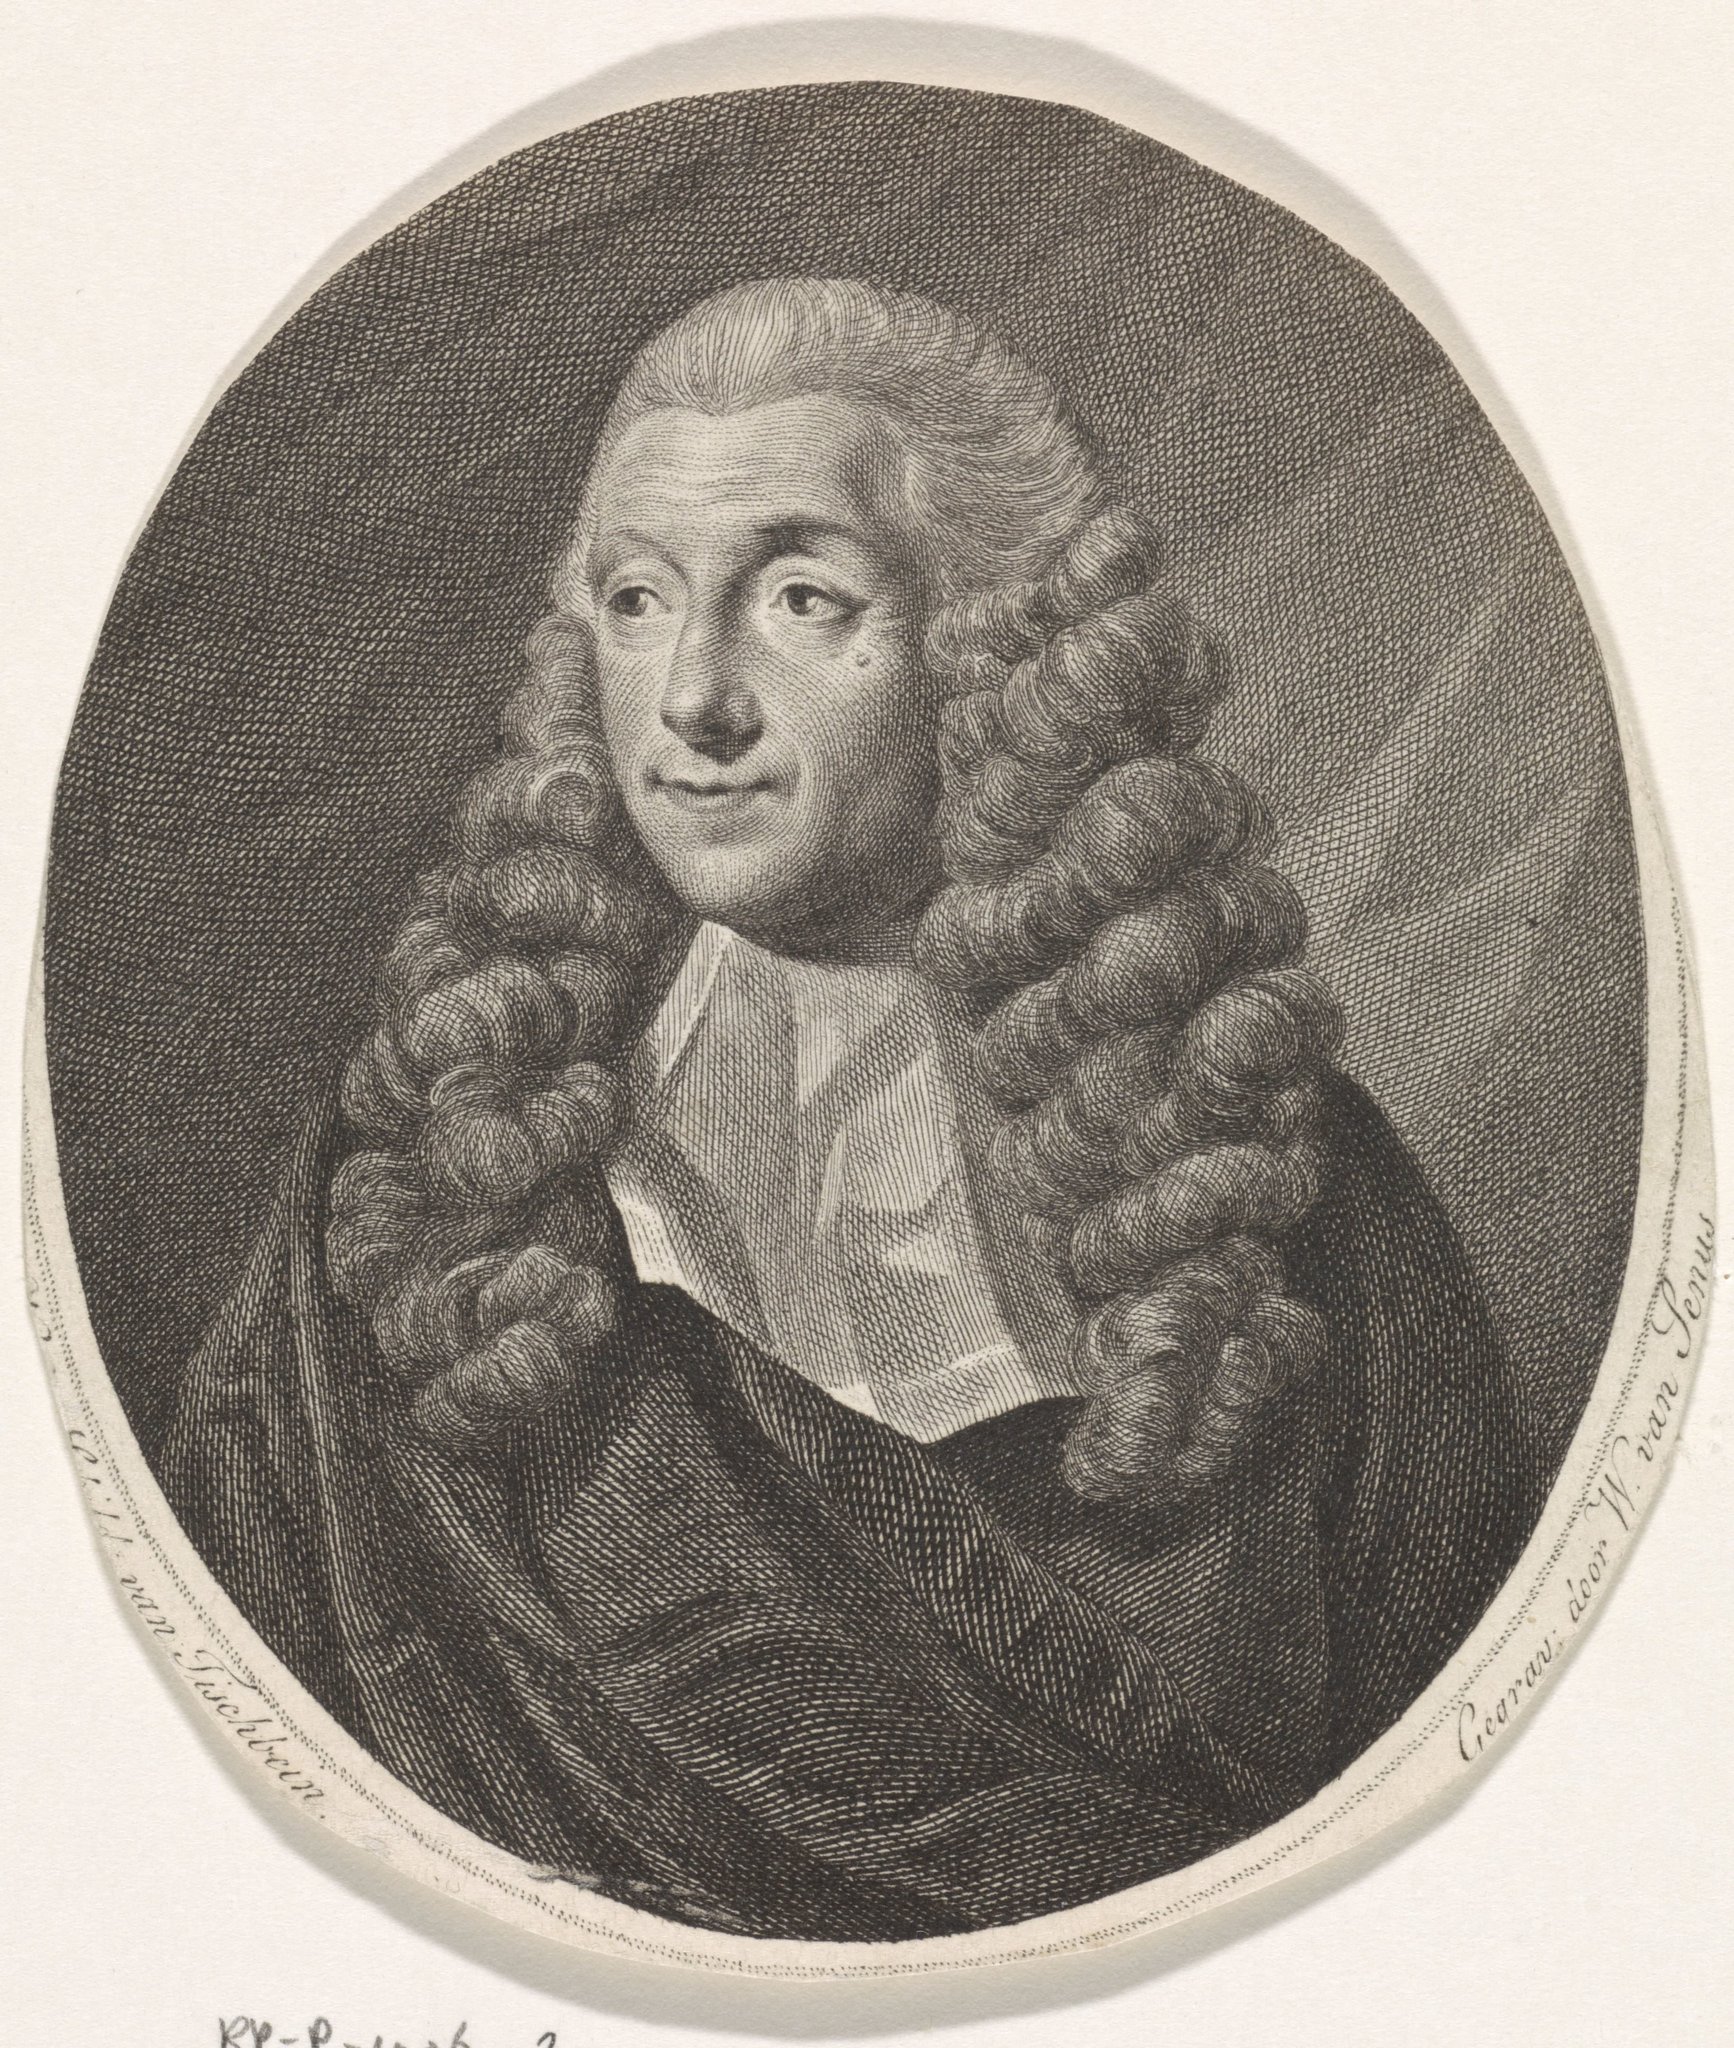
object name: print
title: Portret van Joachim Rendorp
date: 1822-1826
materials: paper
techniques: engraving, etching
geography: netherlands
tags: amsterdam, joachim rendorp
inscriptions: collector's mark: Lugt 2228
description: Prent mogelijk gebruikt in: Stuart, Martinus. Vaderlandsche historie, vervattende de geschiedenissen der Vereenigde Nederlanden, van de vestiging van het Erfstadhouderschap in de mannelijke en vrouwelijke linie, tot aan 's Lands verlossing, uit de inlijving in het Fransche Keizerrijk. Amsterdam: Evert Maaskamp, 1822-1826.